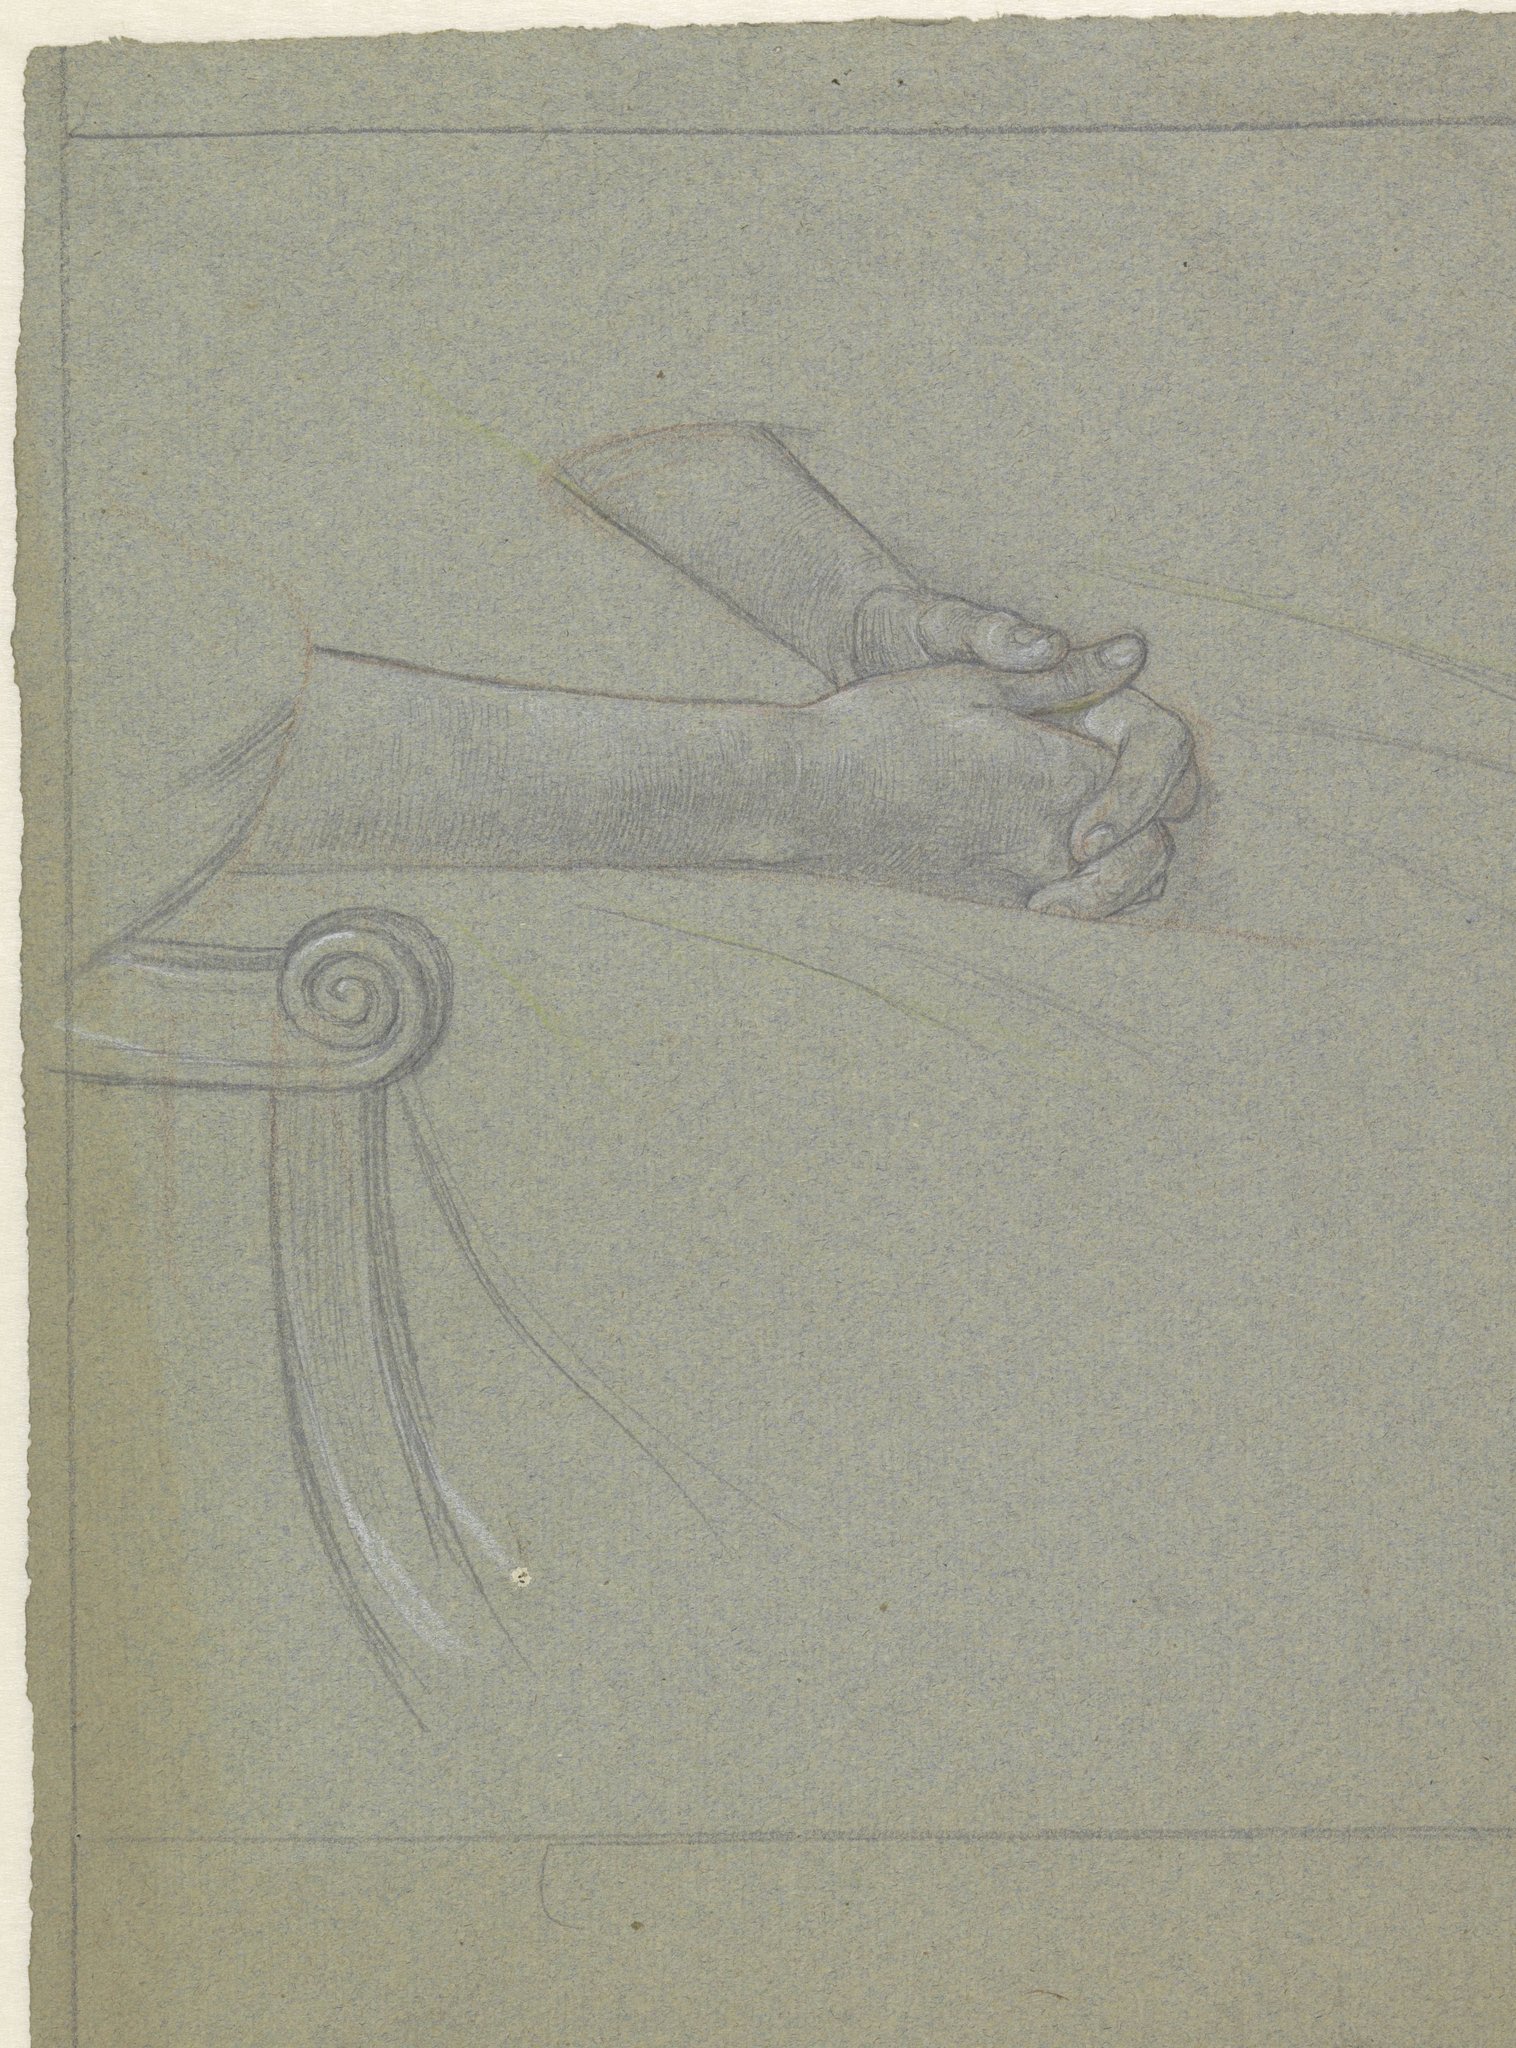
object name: drawing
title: Studie van twee gevouwen handen in de schoot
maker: jan veth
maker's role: designer, draughtsman, painter, print maker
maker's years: 1864-1925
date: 1874-1925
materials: chalk, paper, pencil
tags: hand